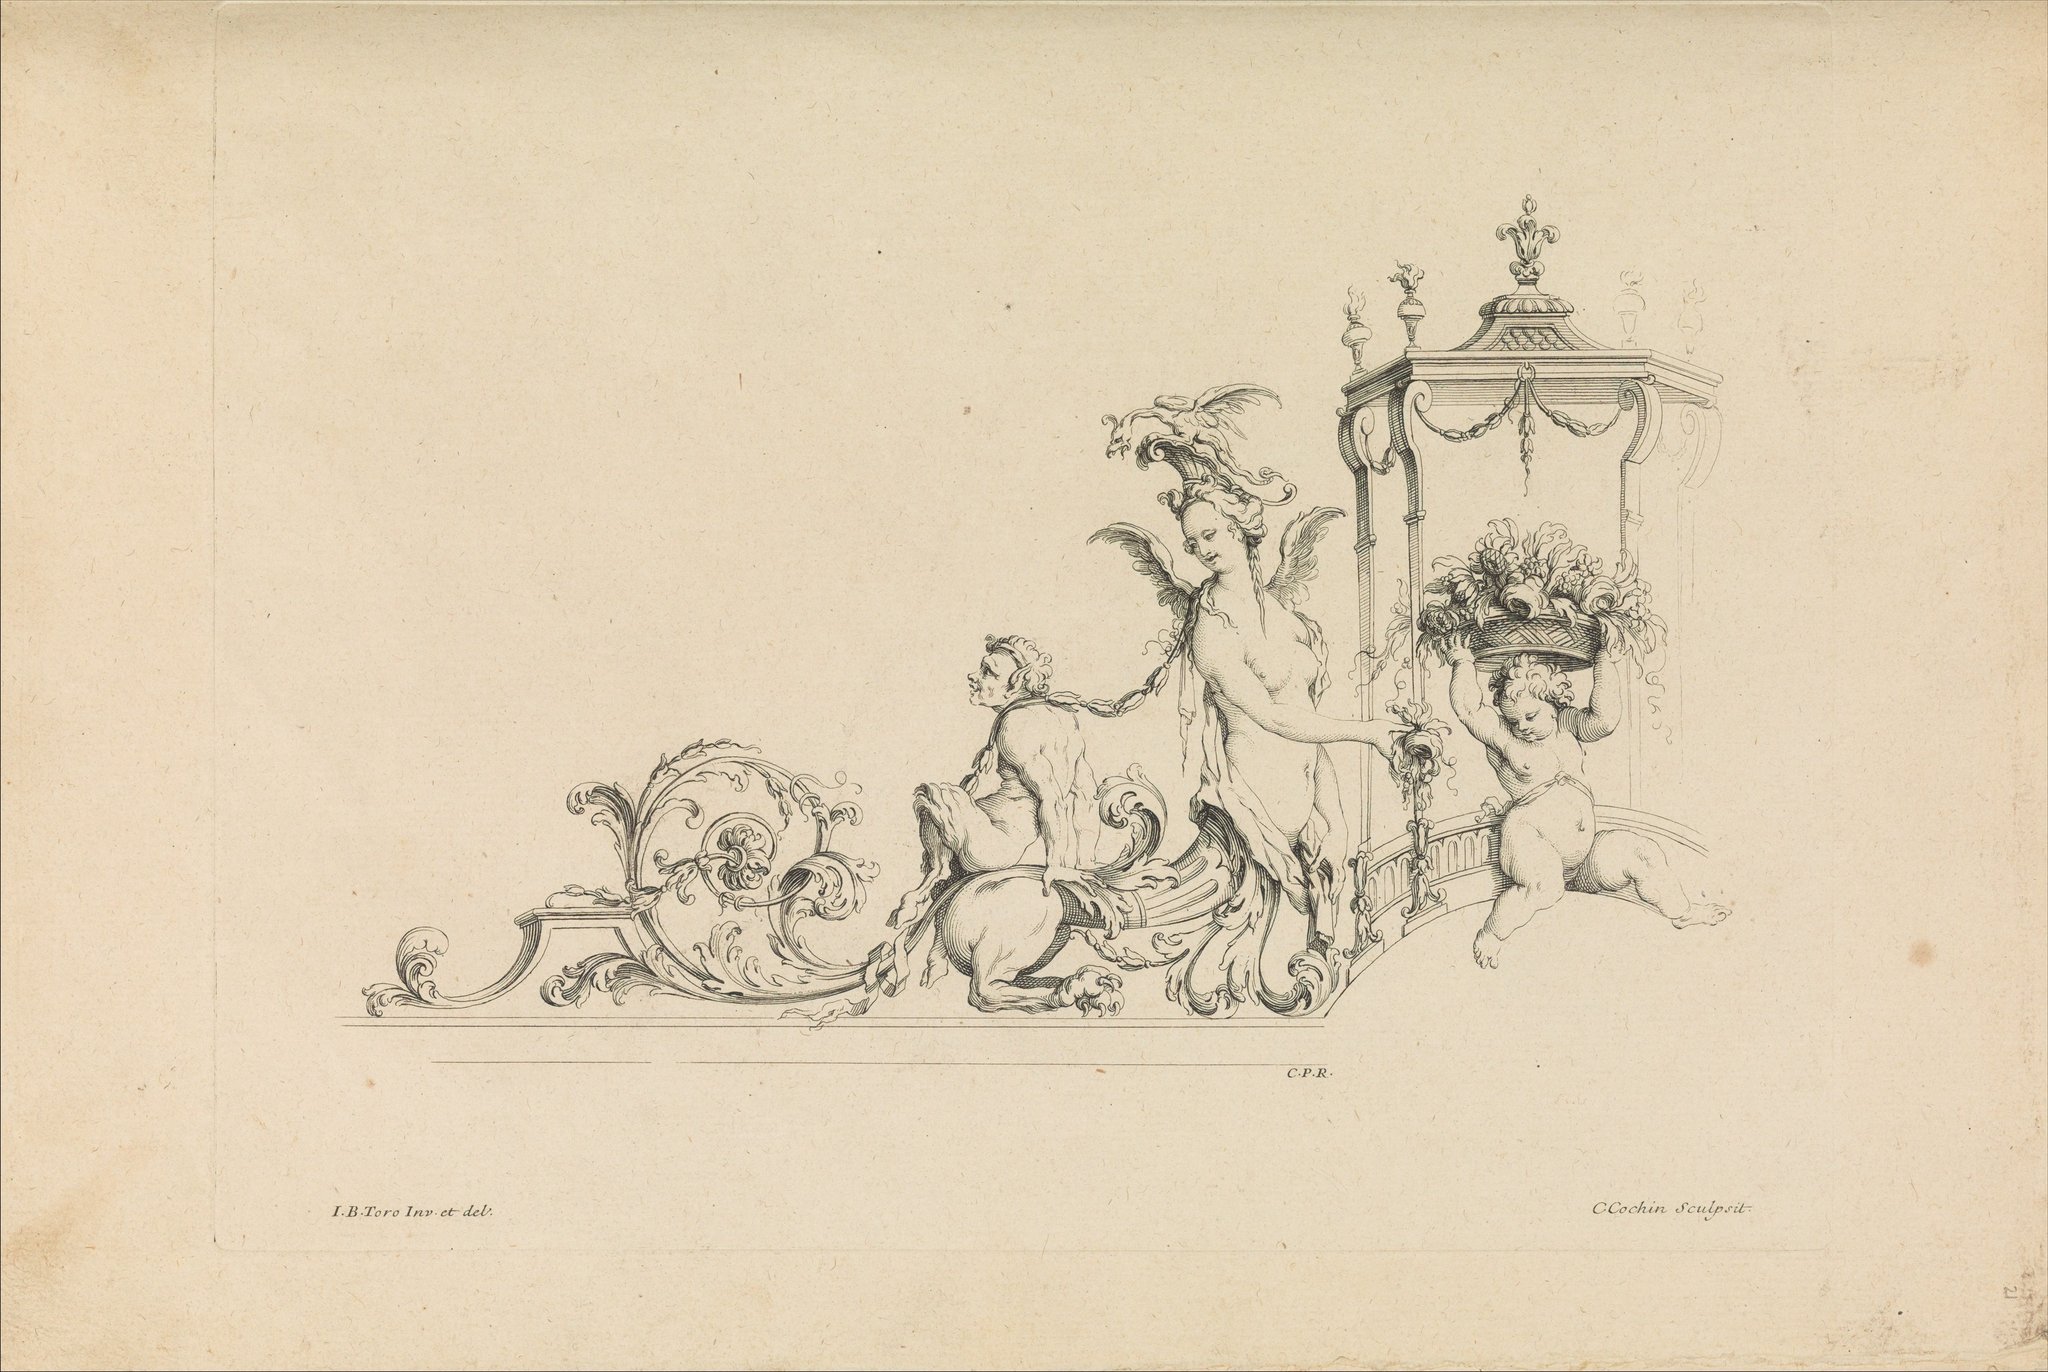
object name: album print ornament architecture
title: Desseins Arabesques a Plusieurs Usages Inventés par J.B. Toro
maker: jean bernard toro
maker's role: designer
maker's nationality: french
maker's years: 1672-1731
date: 1716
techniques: etching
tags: men